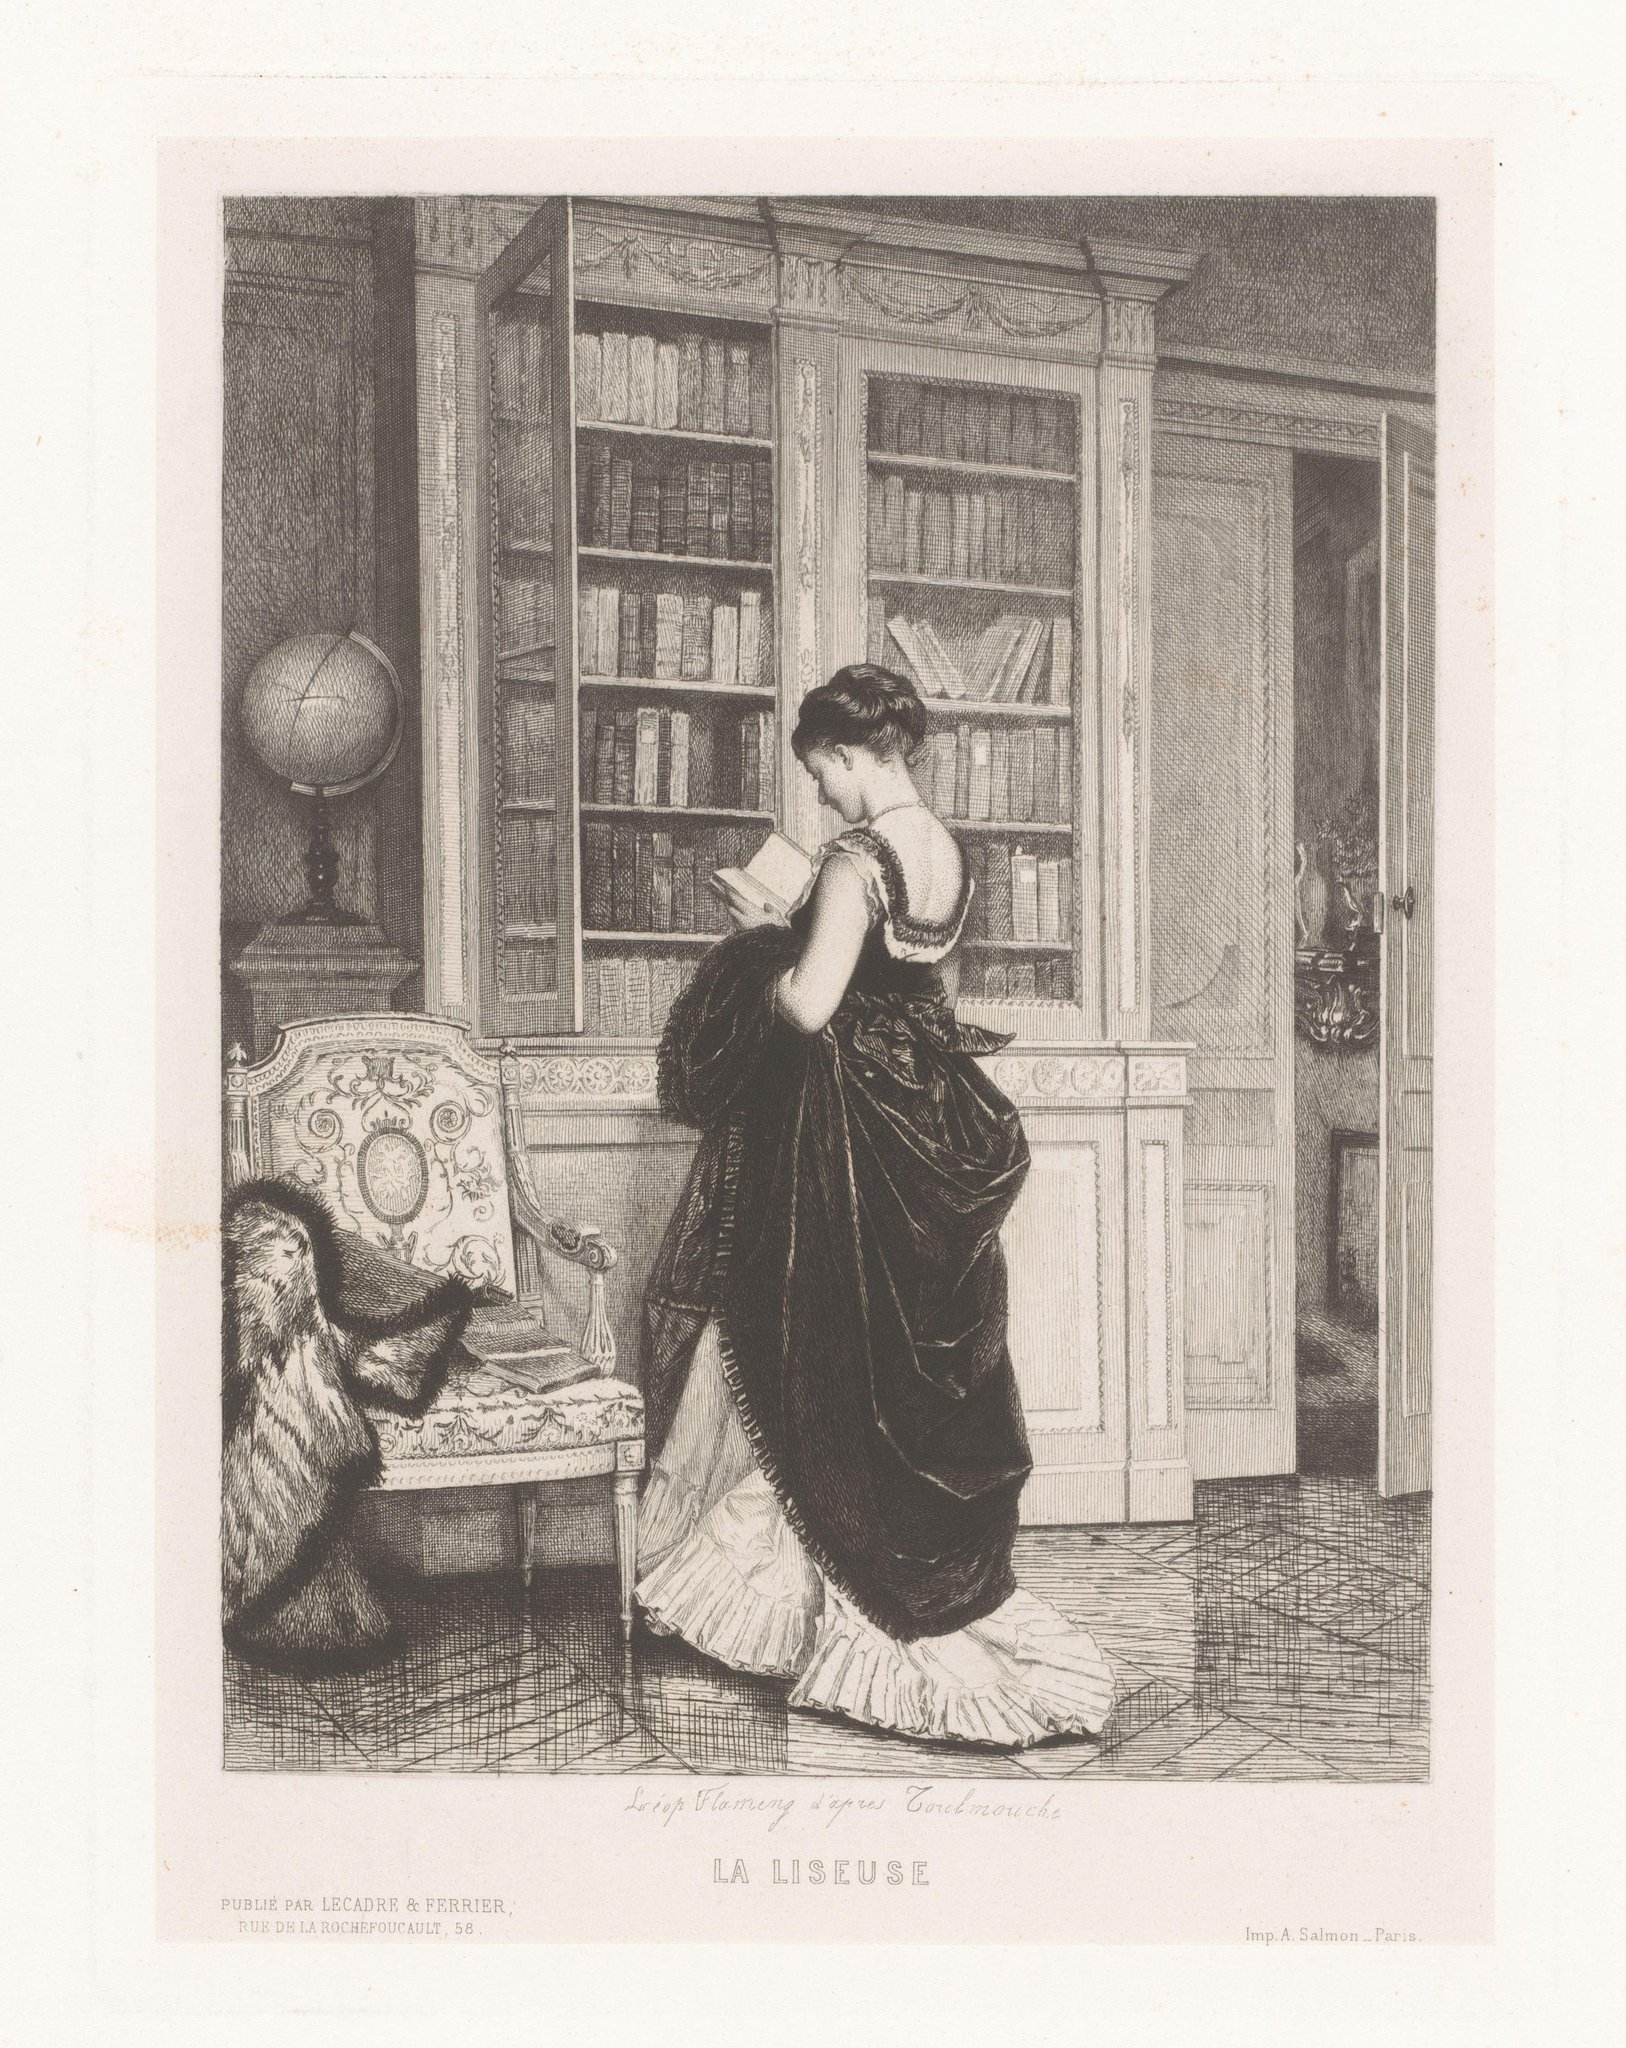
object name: print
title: La liseuse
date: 1841-1892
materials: paper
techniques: etching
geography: paris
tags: reading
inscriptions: collector's mark: Lugt 2228